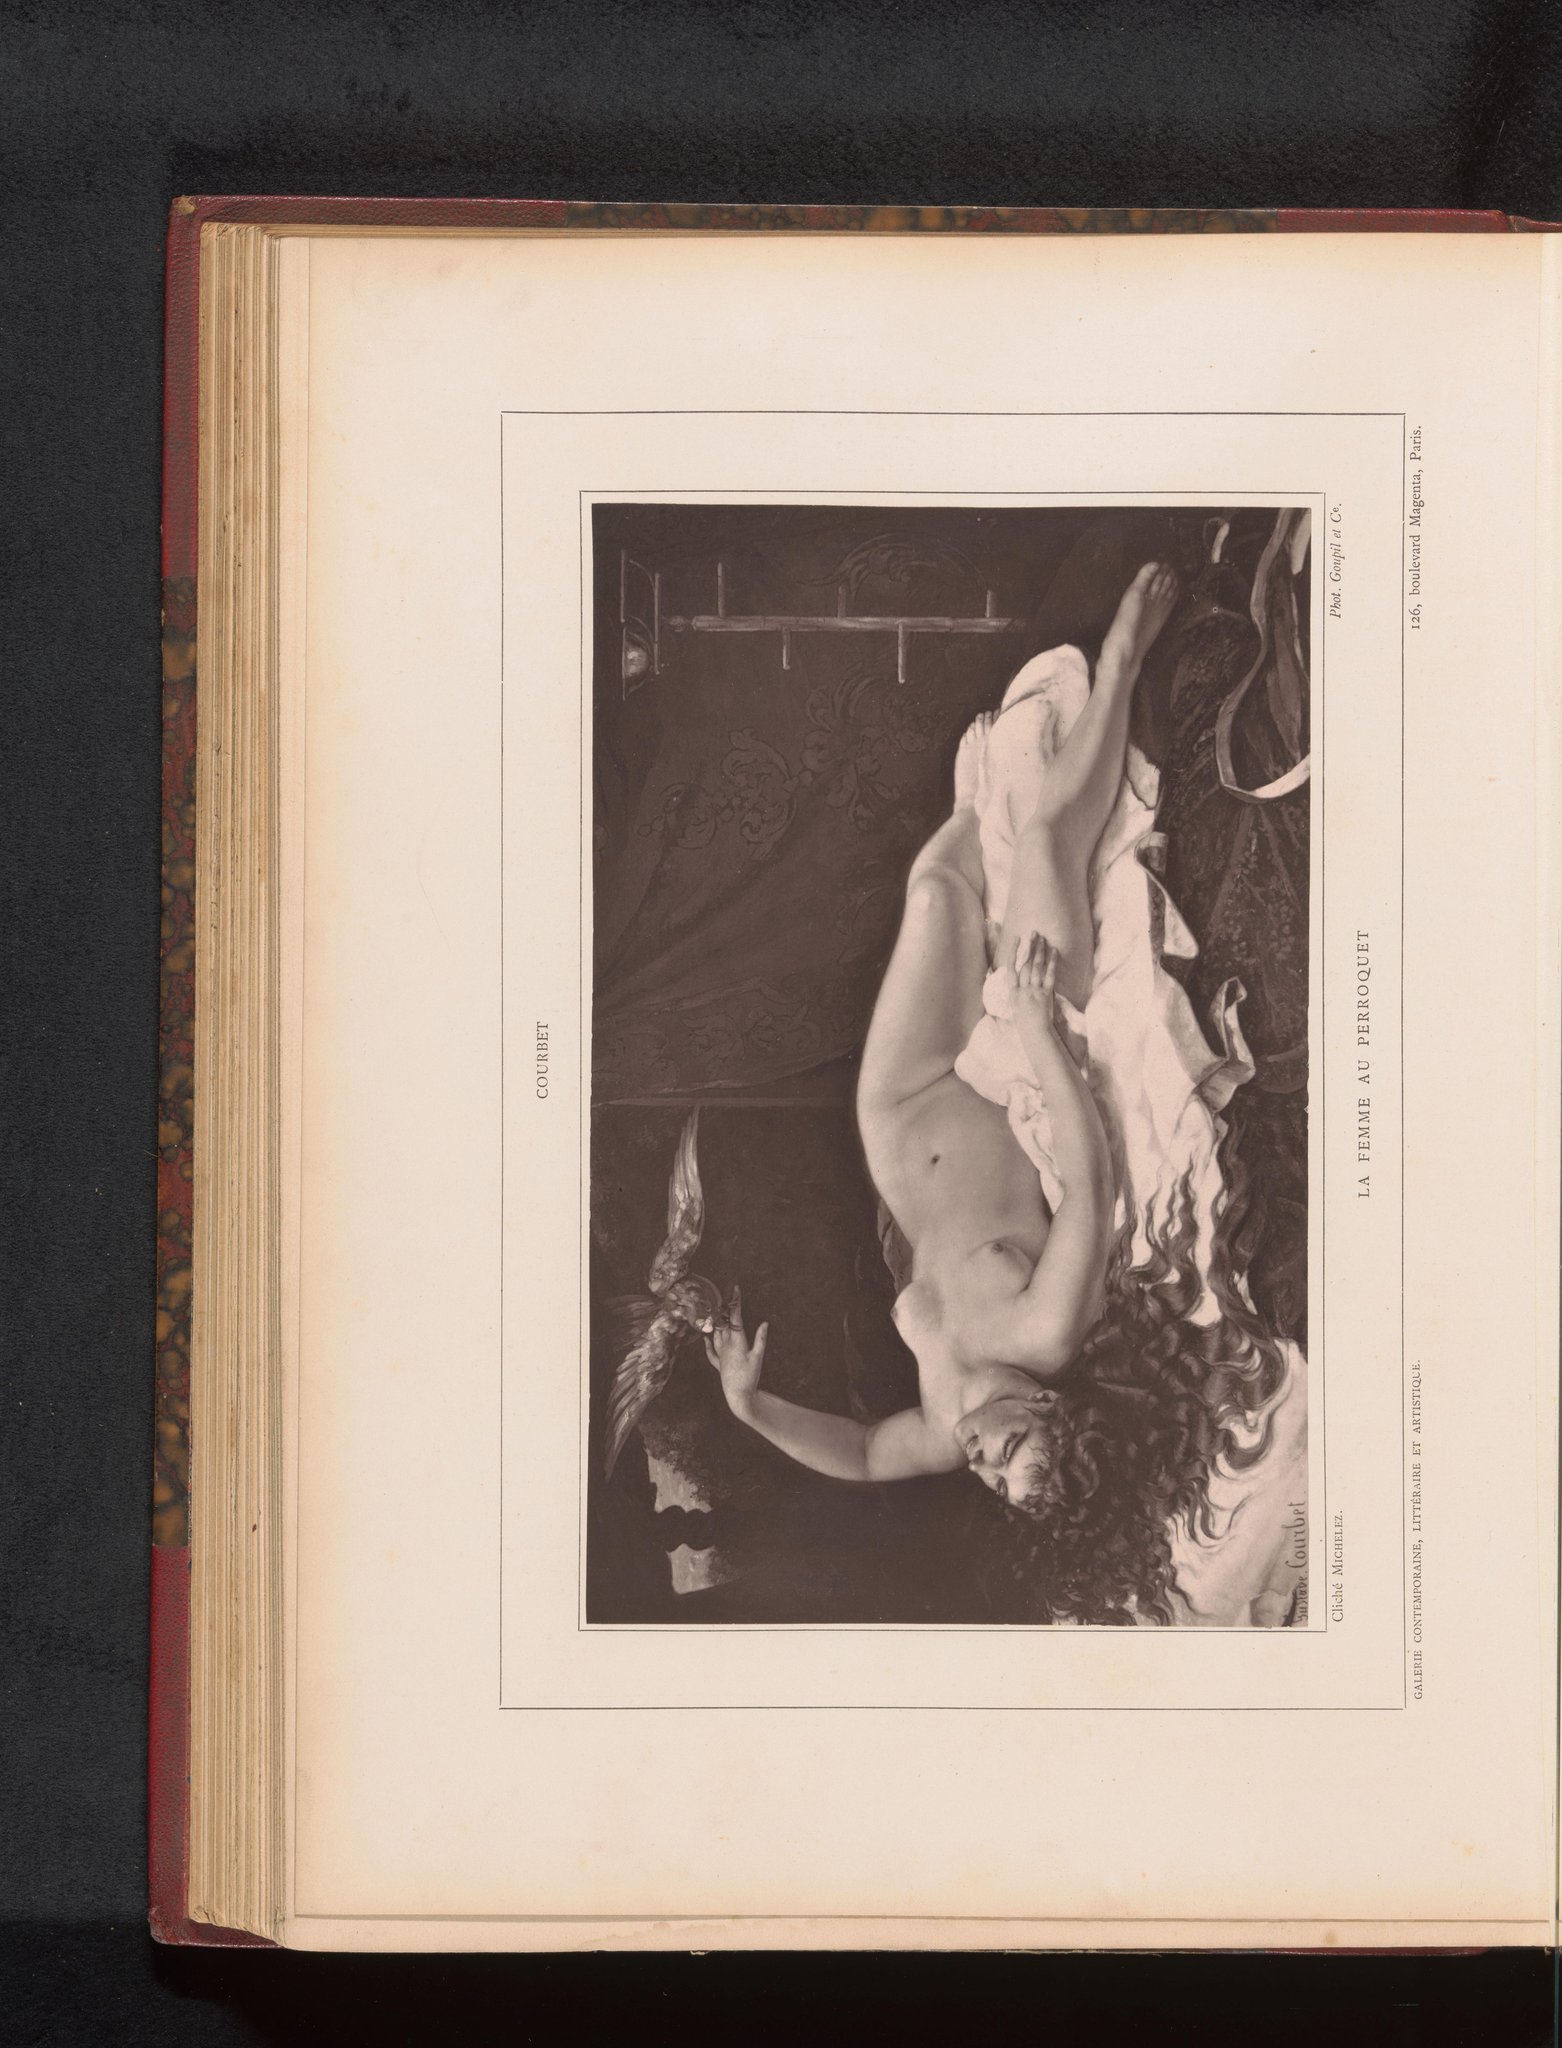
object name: page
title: La femme au perroquet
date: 1878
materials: paper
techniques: woodburytype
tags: print maker, draughtsman, henri joseph harpignies, ornamental birds: parrot, the (nude) human figure; 'corpo humano' (ripa) - aa - female human figure, lying figure - aa - female human figure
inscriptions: inscription: ‘Galerie Contemporaine, Littéraire, Artistique/ 126, boulevard Magenta, Paris.’